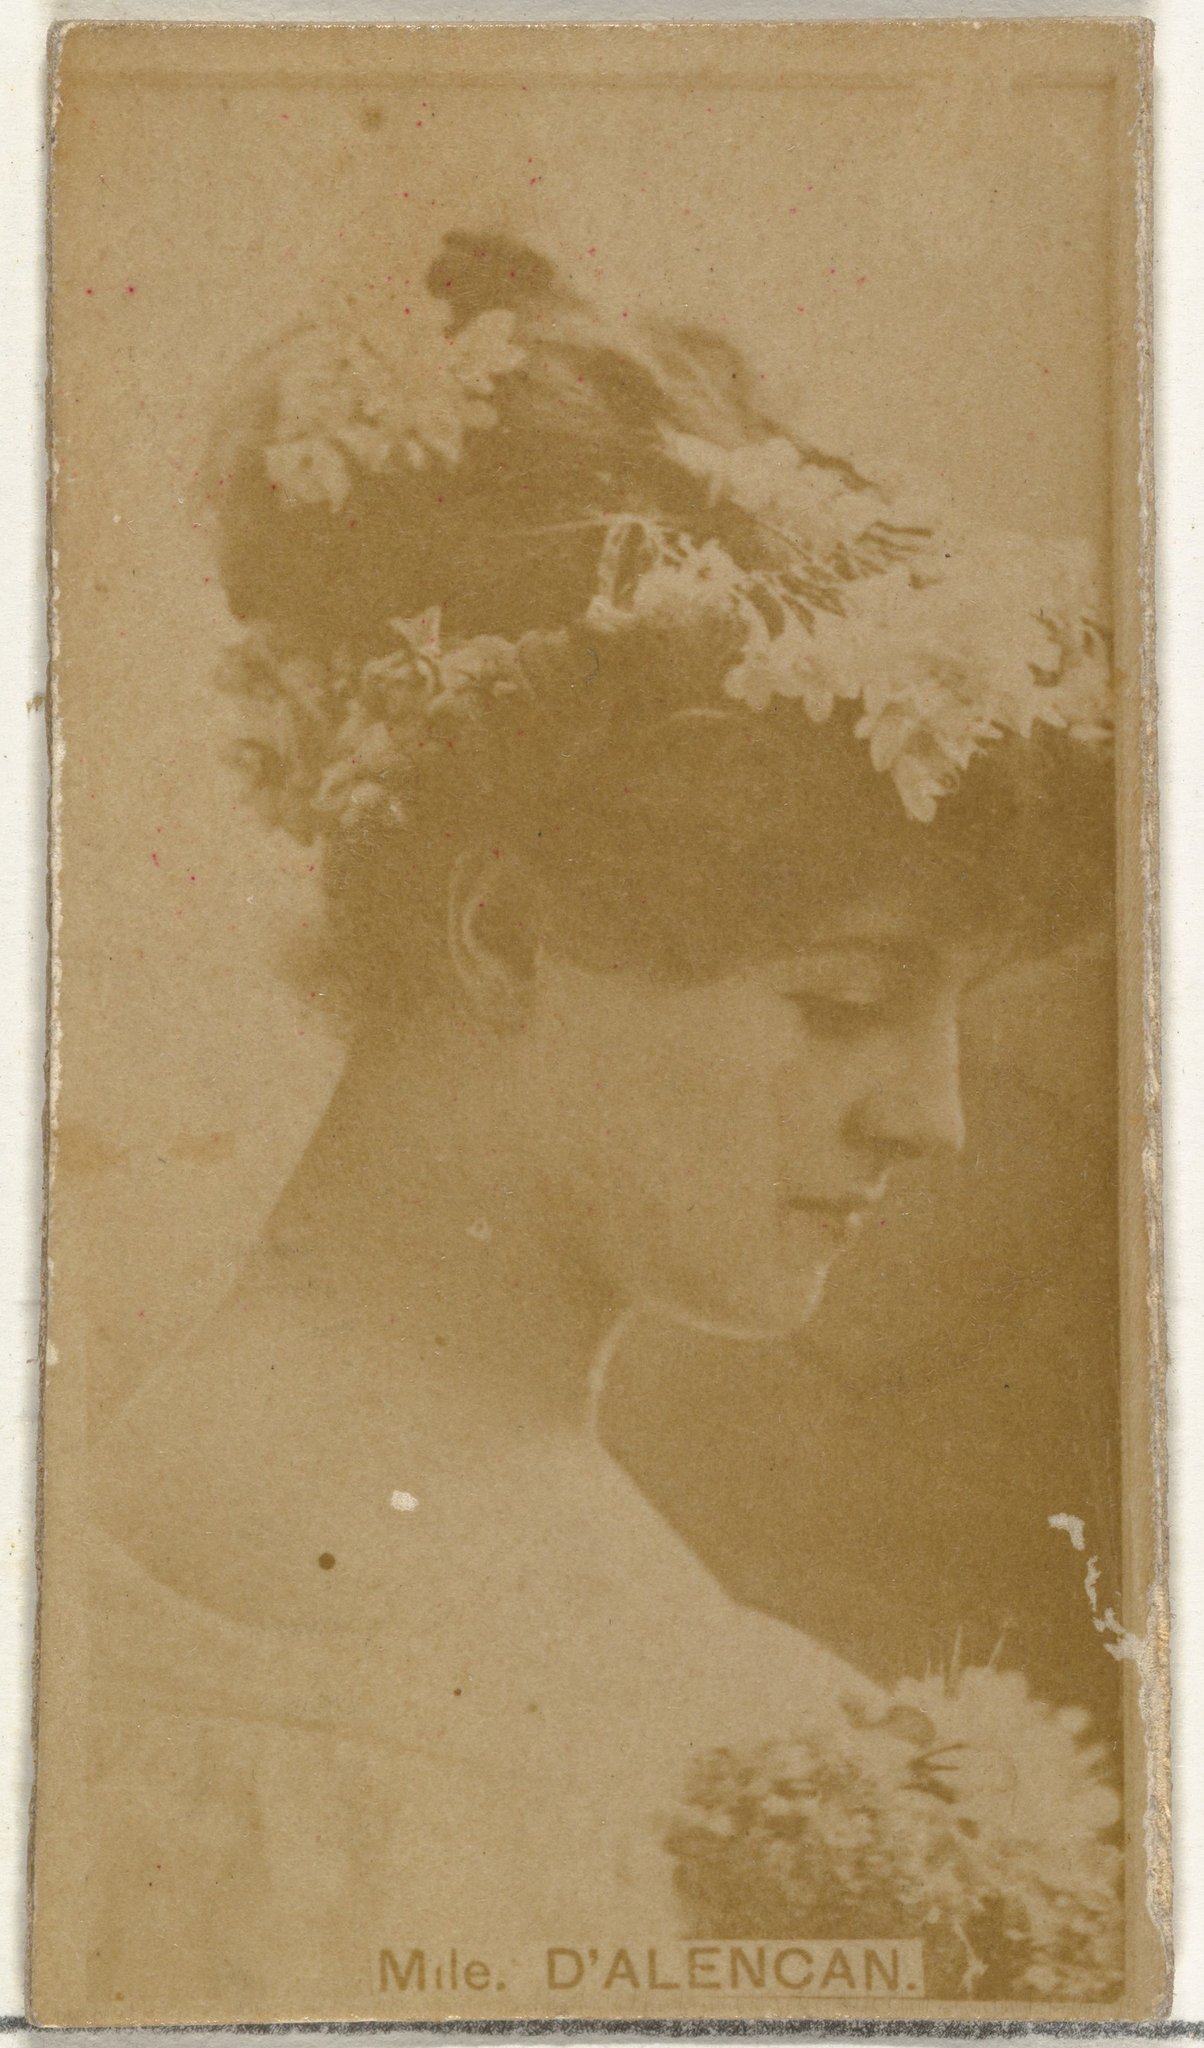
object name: photograph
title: Mlle. D'Alencan, from the Actors and Actresses series (N145-8) issued by Duke Sons & Co. to promote Duke Cigarettes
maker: w. duke, sons & co.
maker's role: publisher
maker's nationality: american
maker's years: 1870-1920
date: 1891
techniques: albumen silver print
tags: portraits,women,actresses